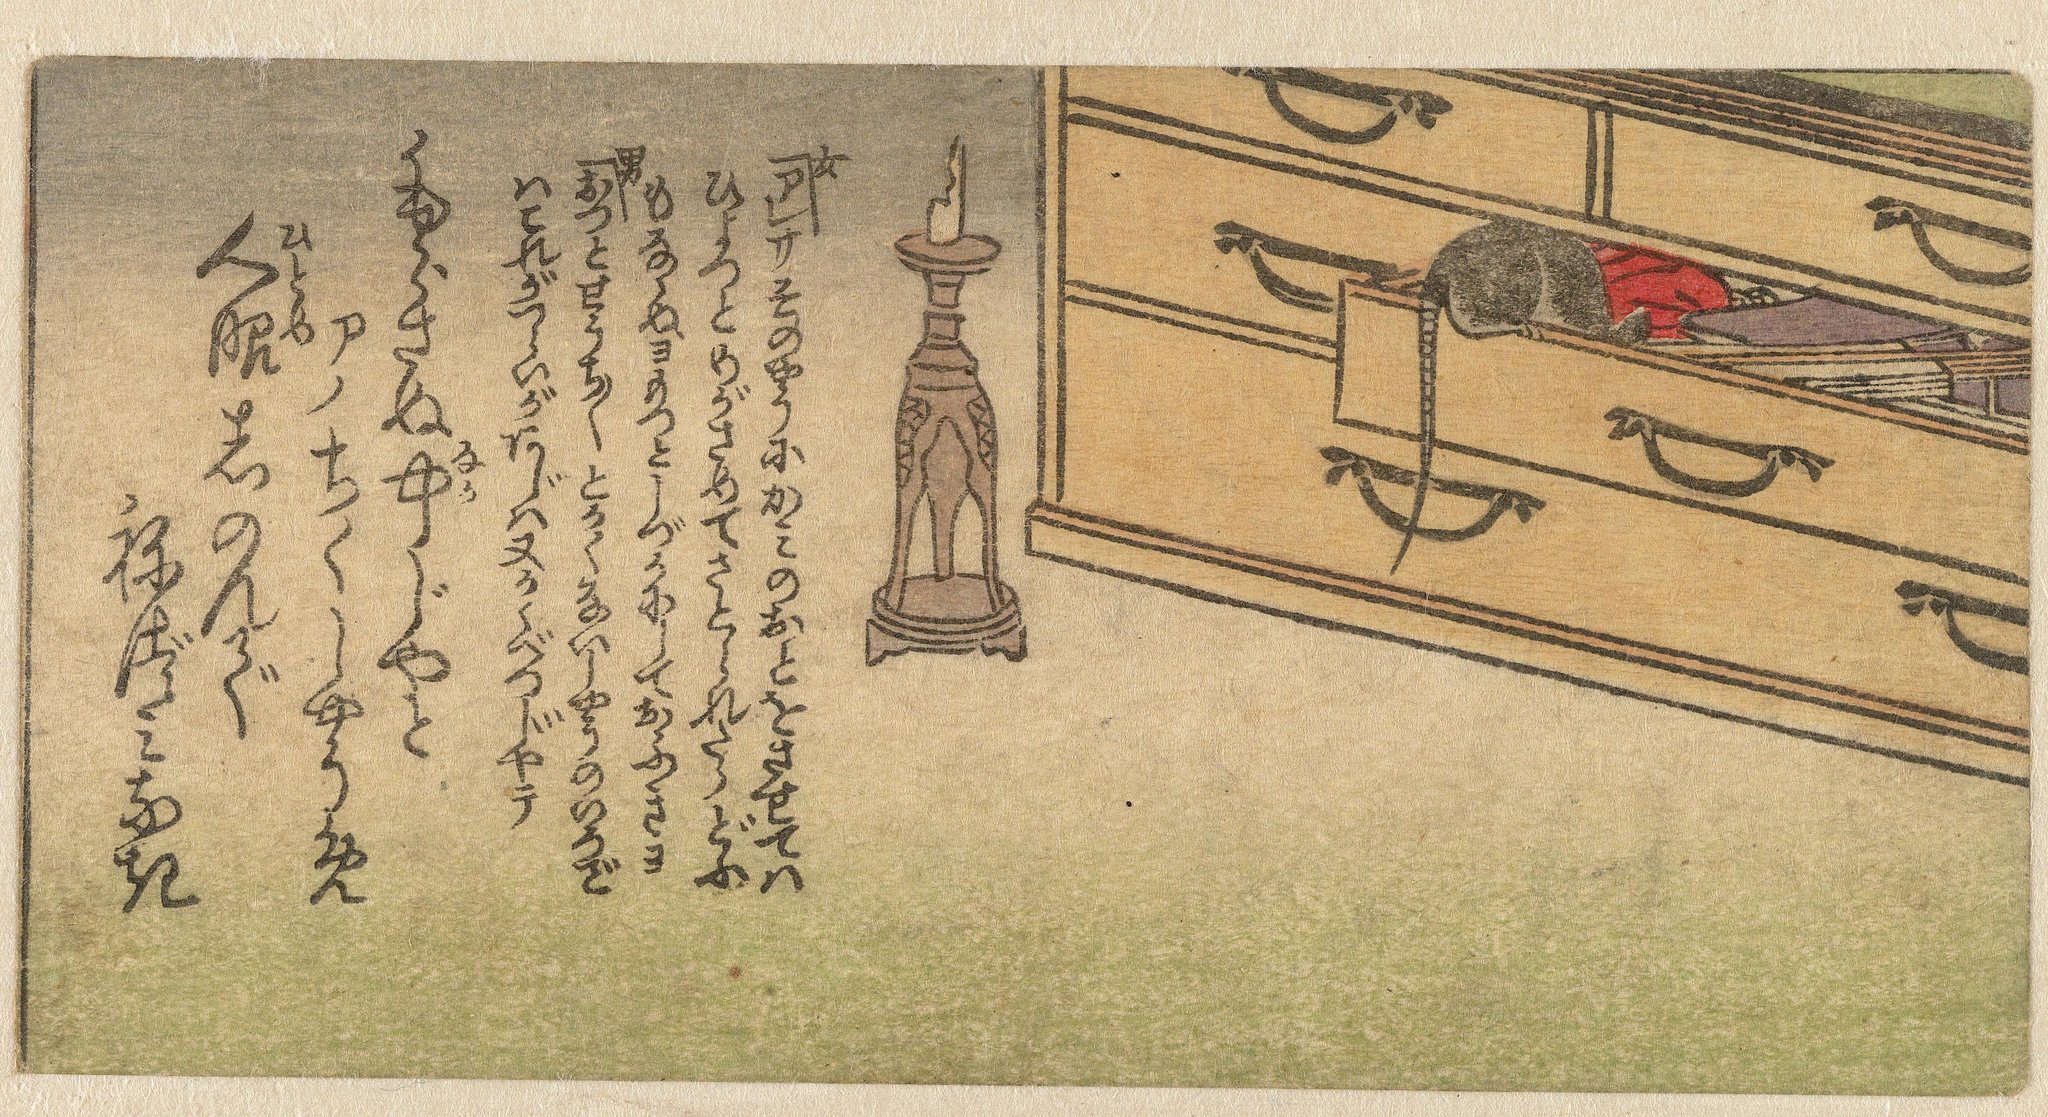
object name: print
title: Waaierserie met begeleidende prenten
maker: Anonymous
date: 1850-1860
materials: paper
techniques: woodcut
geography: japan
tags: furniture for storage, rodents: mouse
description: Een muis snuffelt in de openstaande la van een kast, met een begleidende tekst bij de 'muisgeknaagde waaier'.